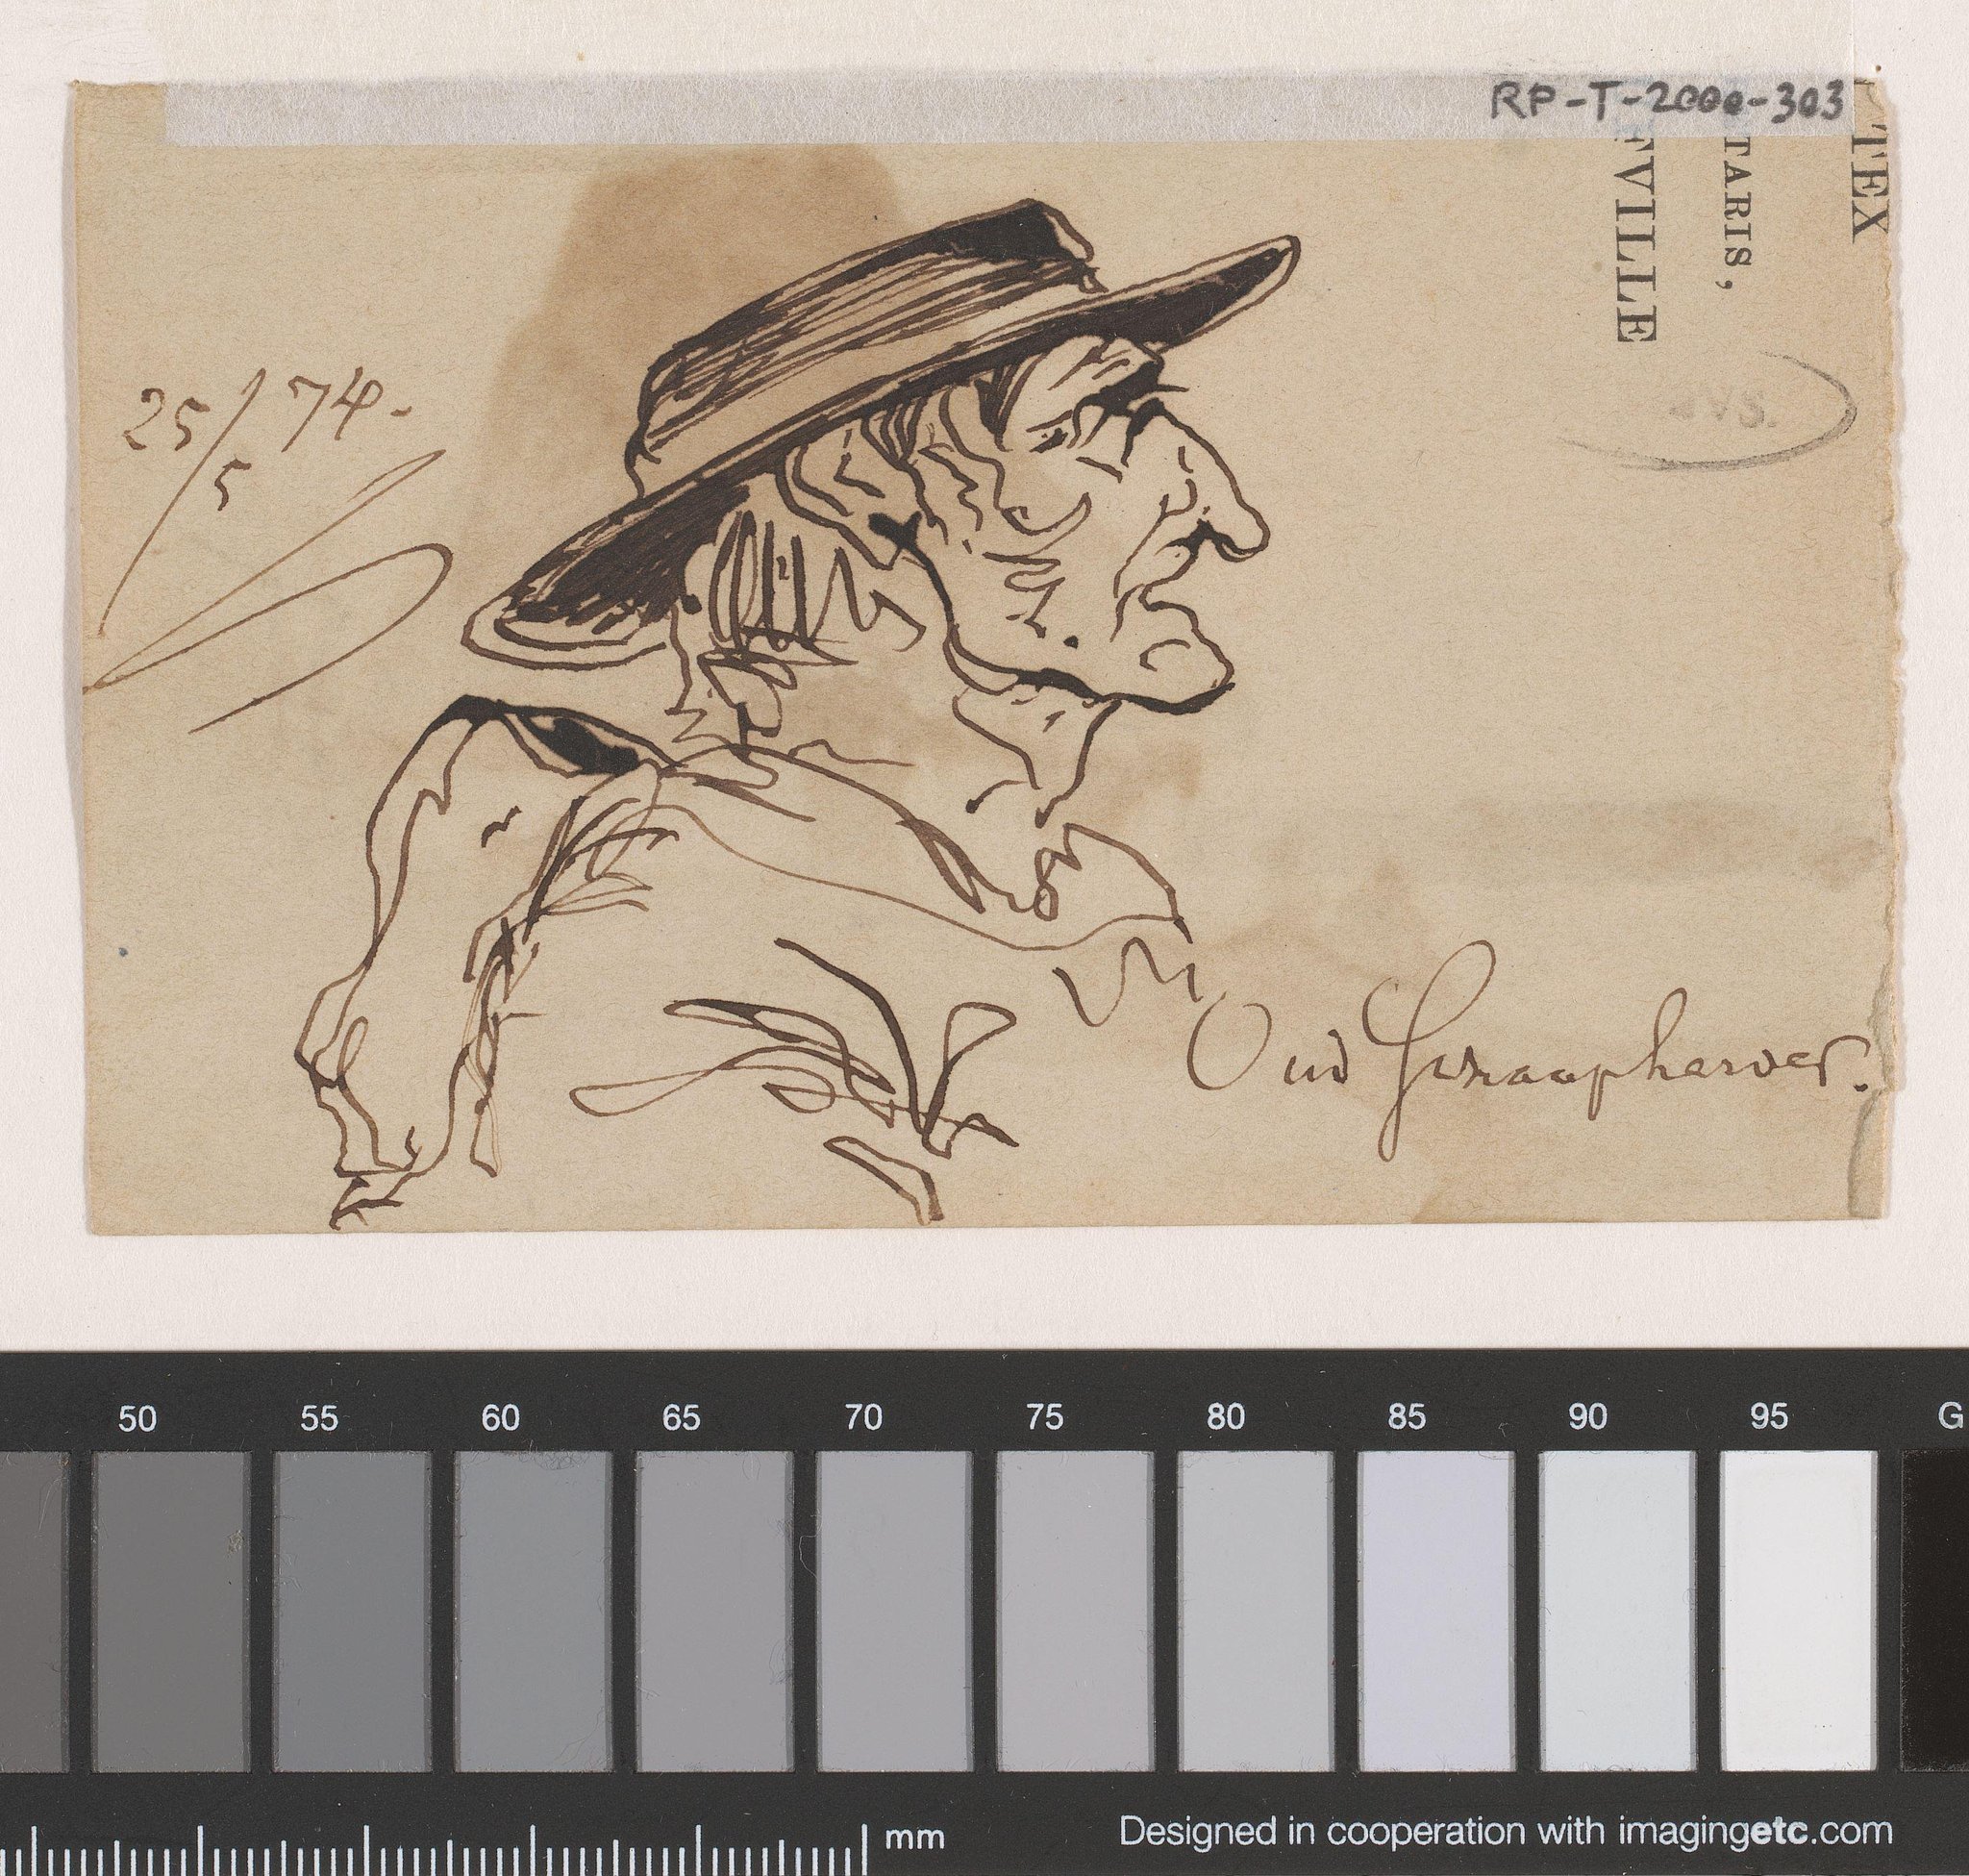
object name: drawing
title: Oud schaapharder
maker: johannes tavenraat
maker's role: draughtsman, painter, print maker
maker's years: 1809-1881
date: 1874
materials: ink, paper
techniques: pen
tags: caricatures (human types), herding, herdsman, herdswoman, shepherd, shepherdess, cowherd, etc.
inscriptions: date: ‘25/5 74.’, annotation: ‘Oud schaapharder’, collector's mark: Lugt 2228